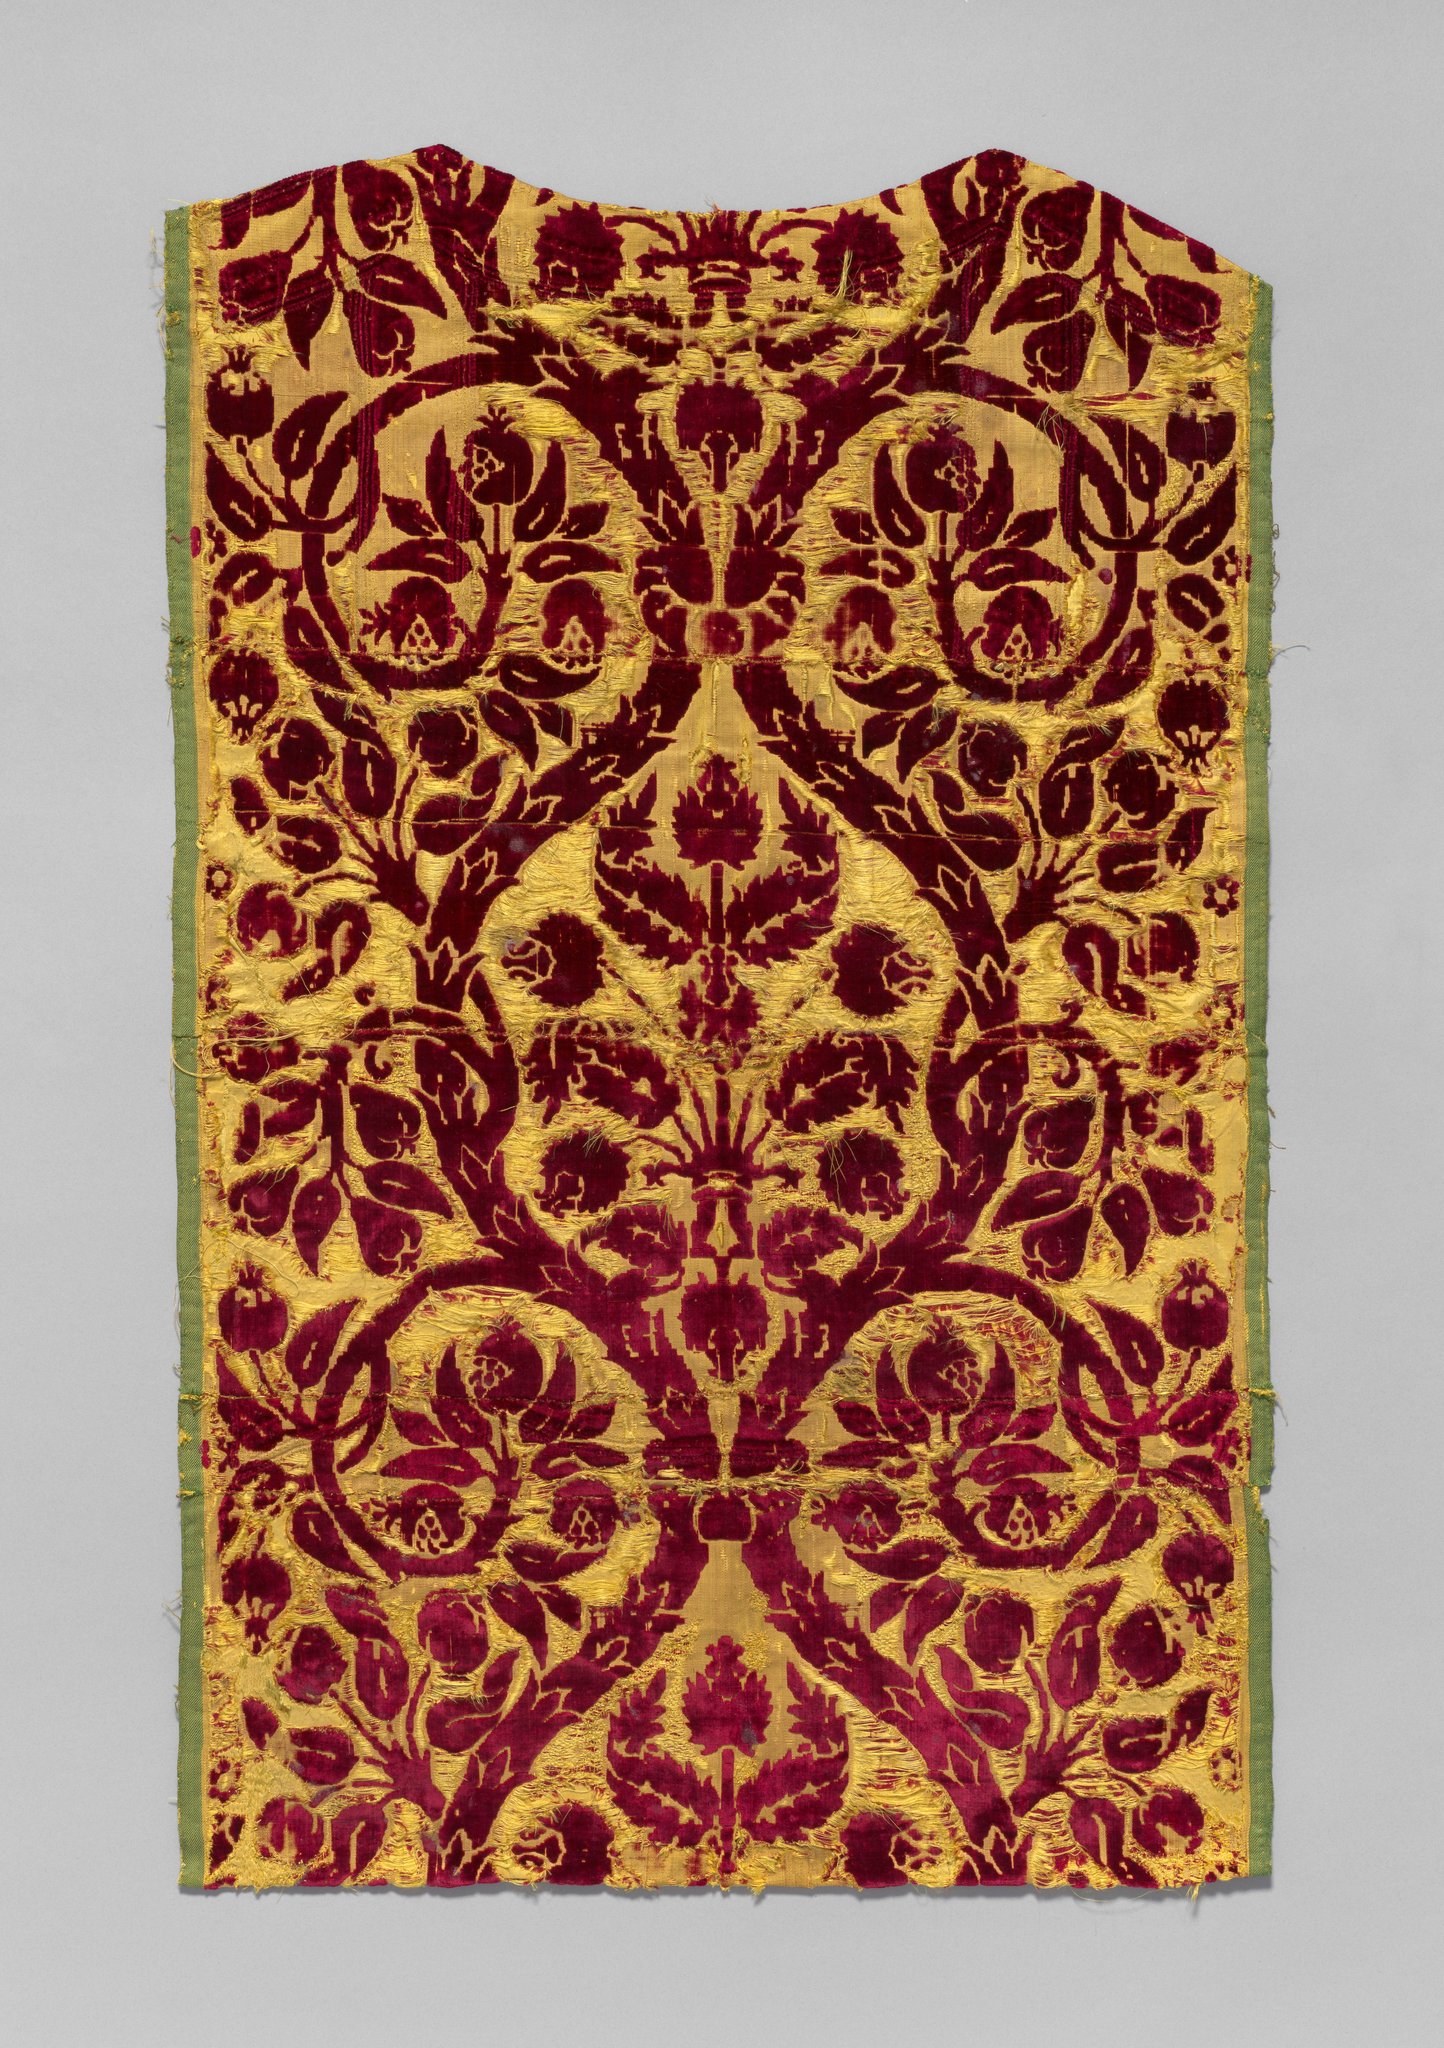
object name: piece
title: Piece with Sempervivum tectorum motif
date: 1475-1500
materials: silk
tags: flowers